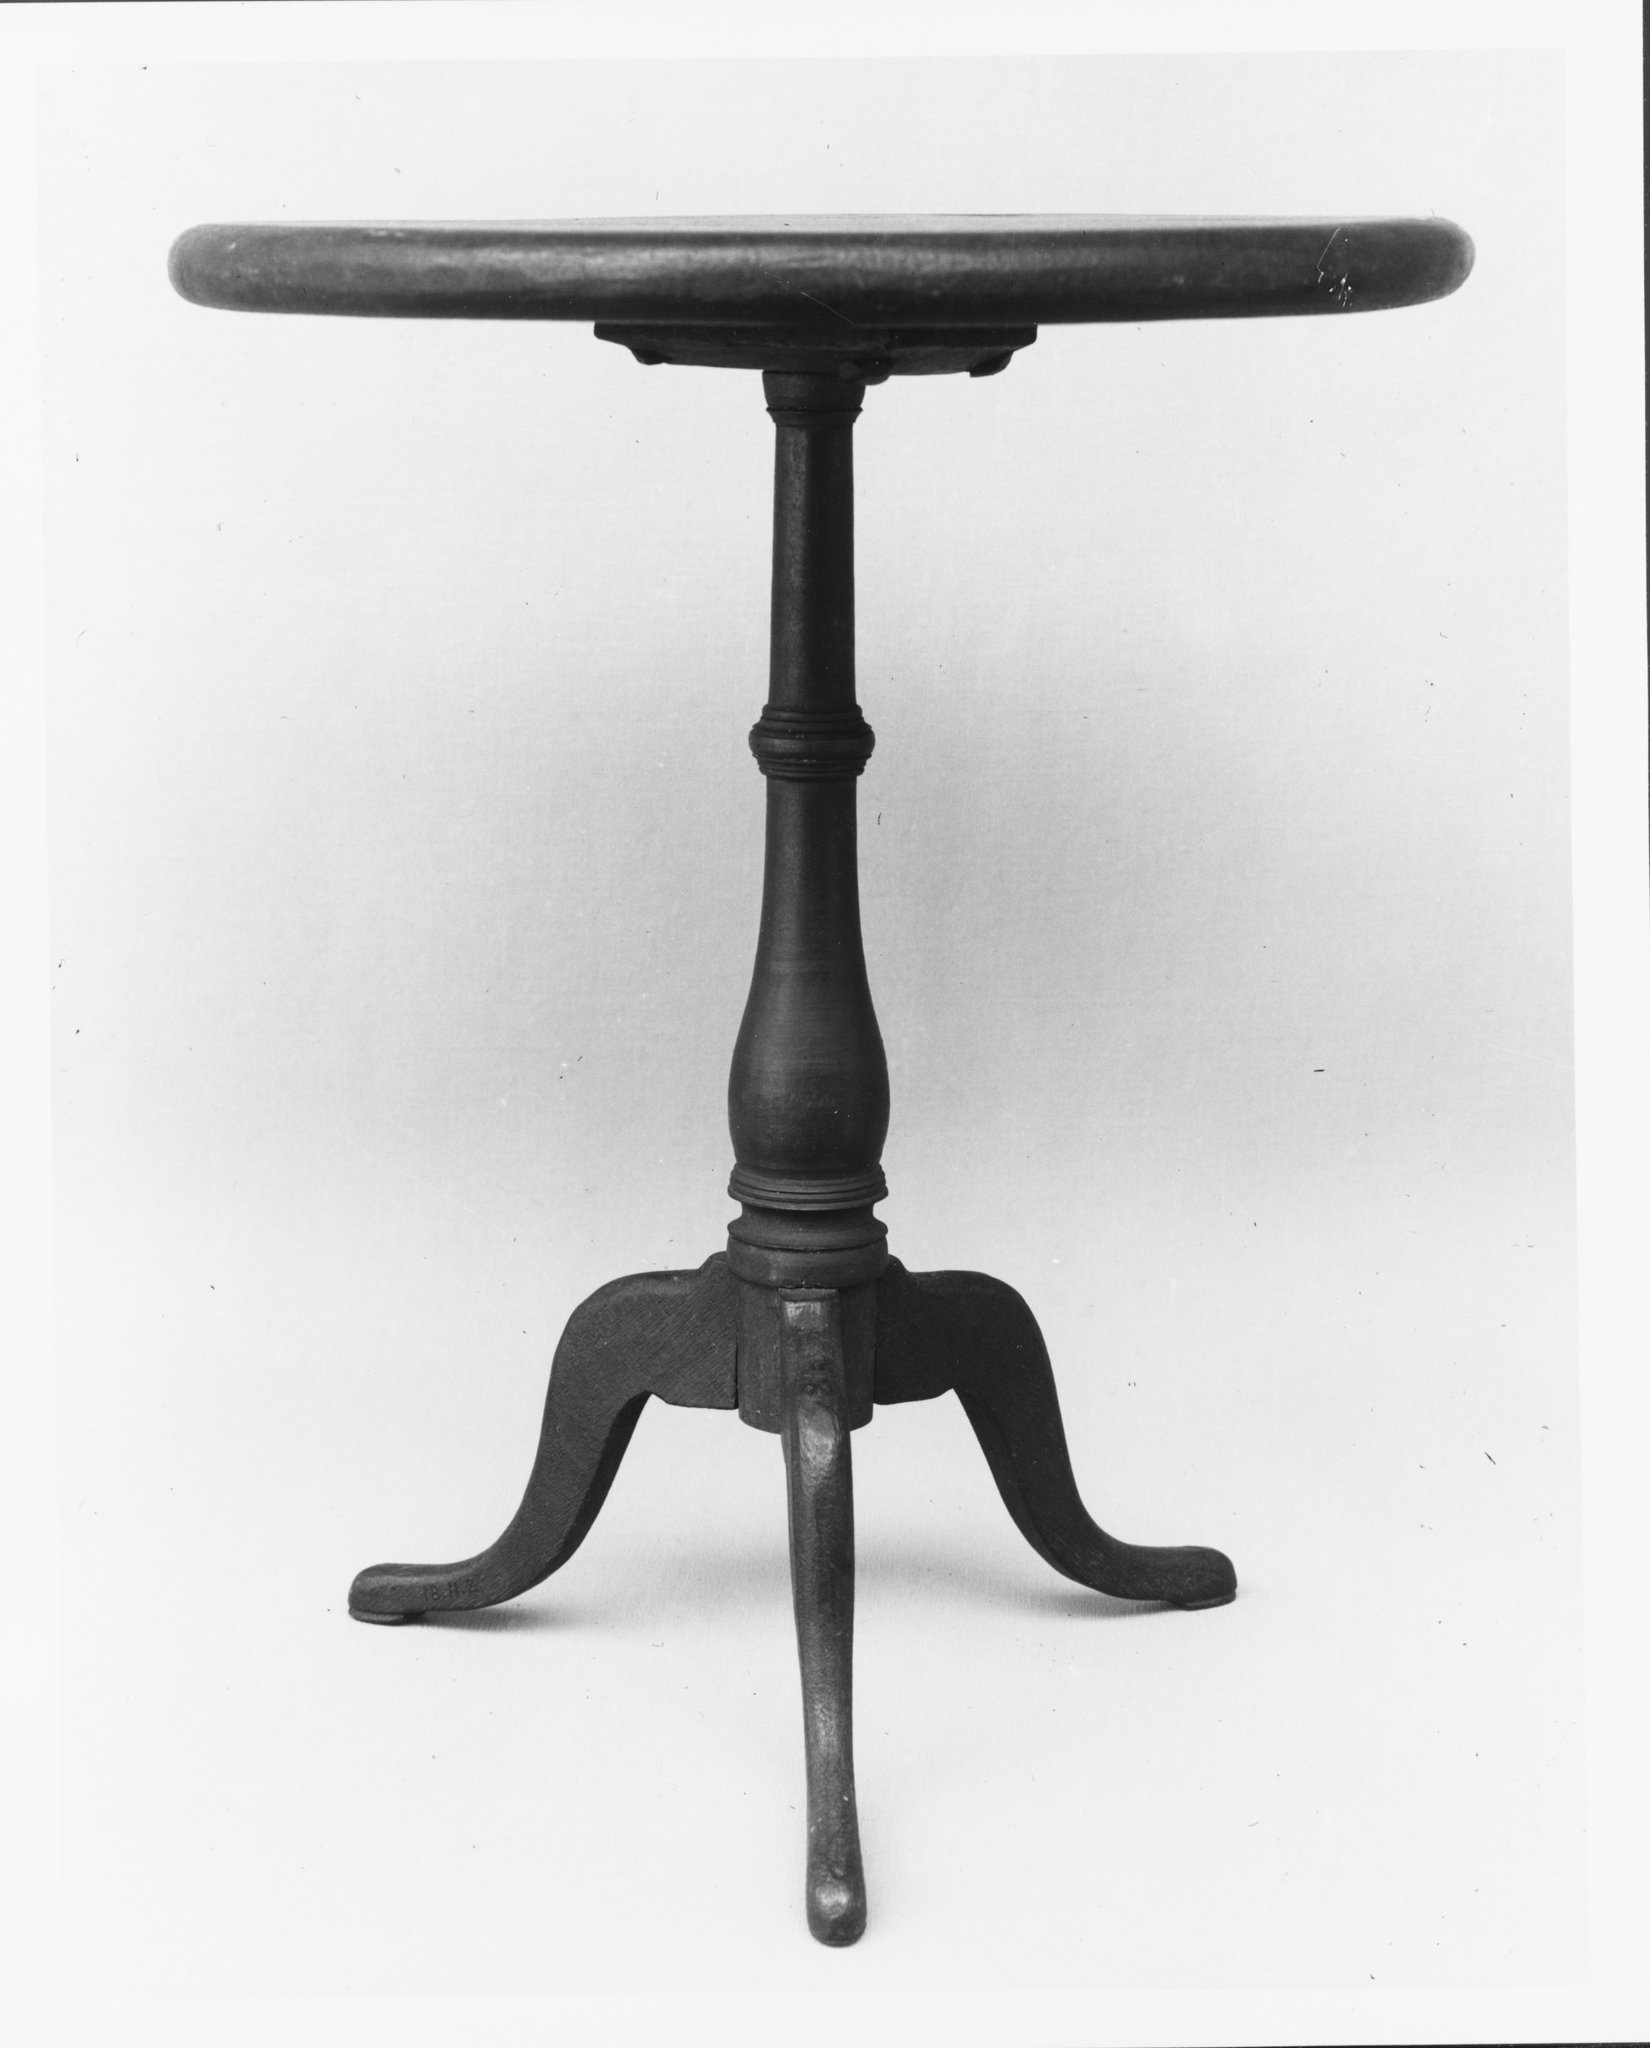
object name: table model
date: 1770-1800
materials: wood